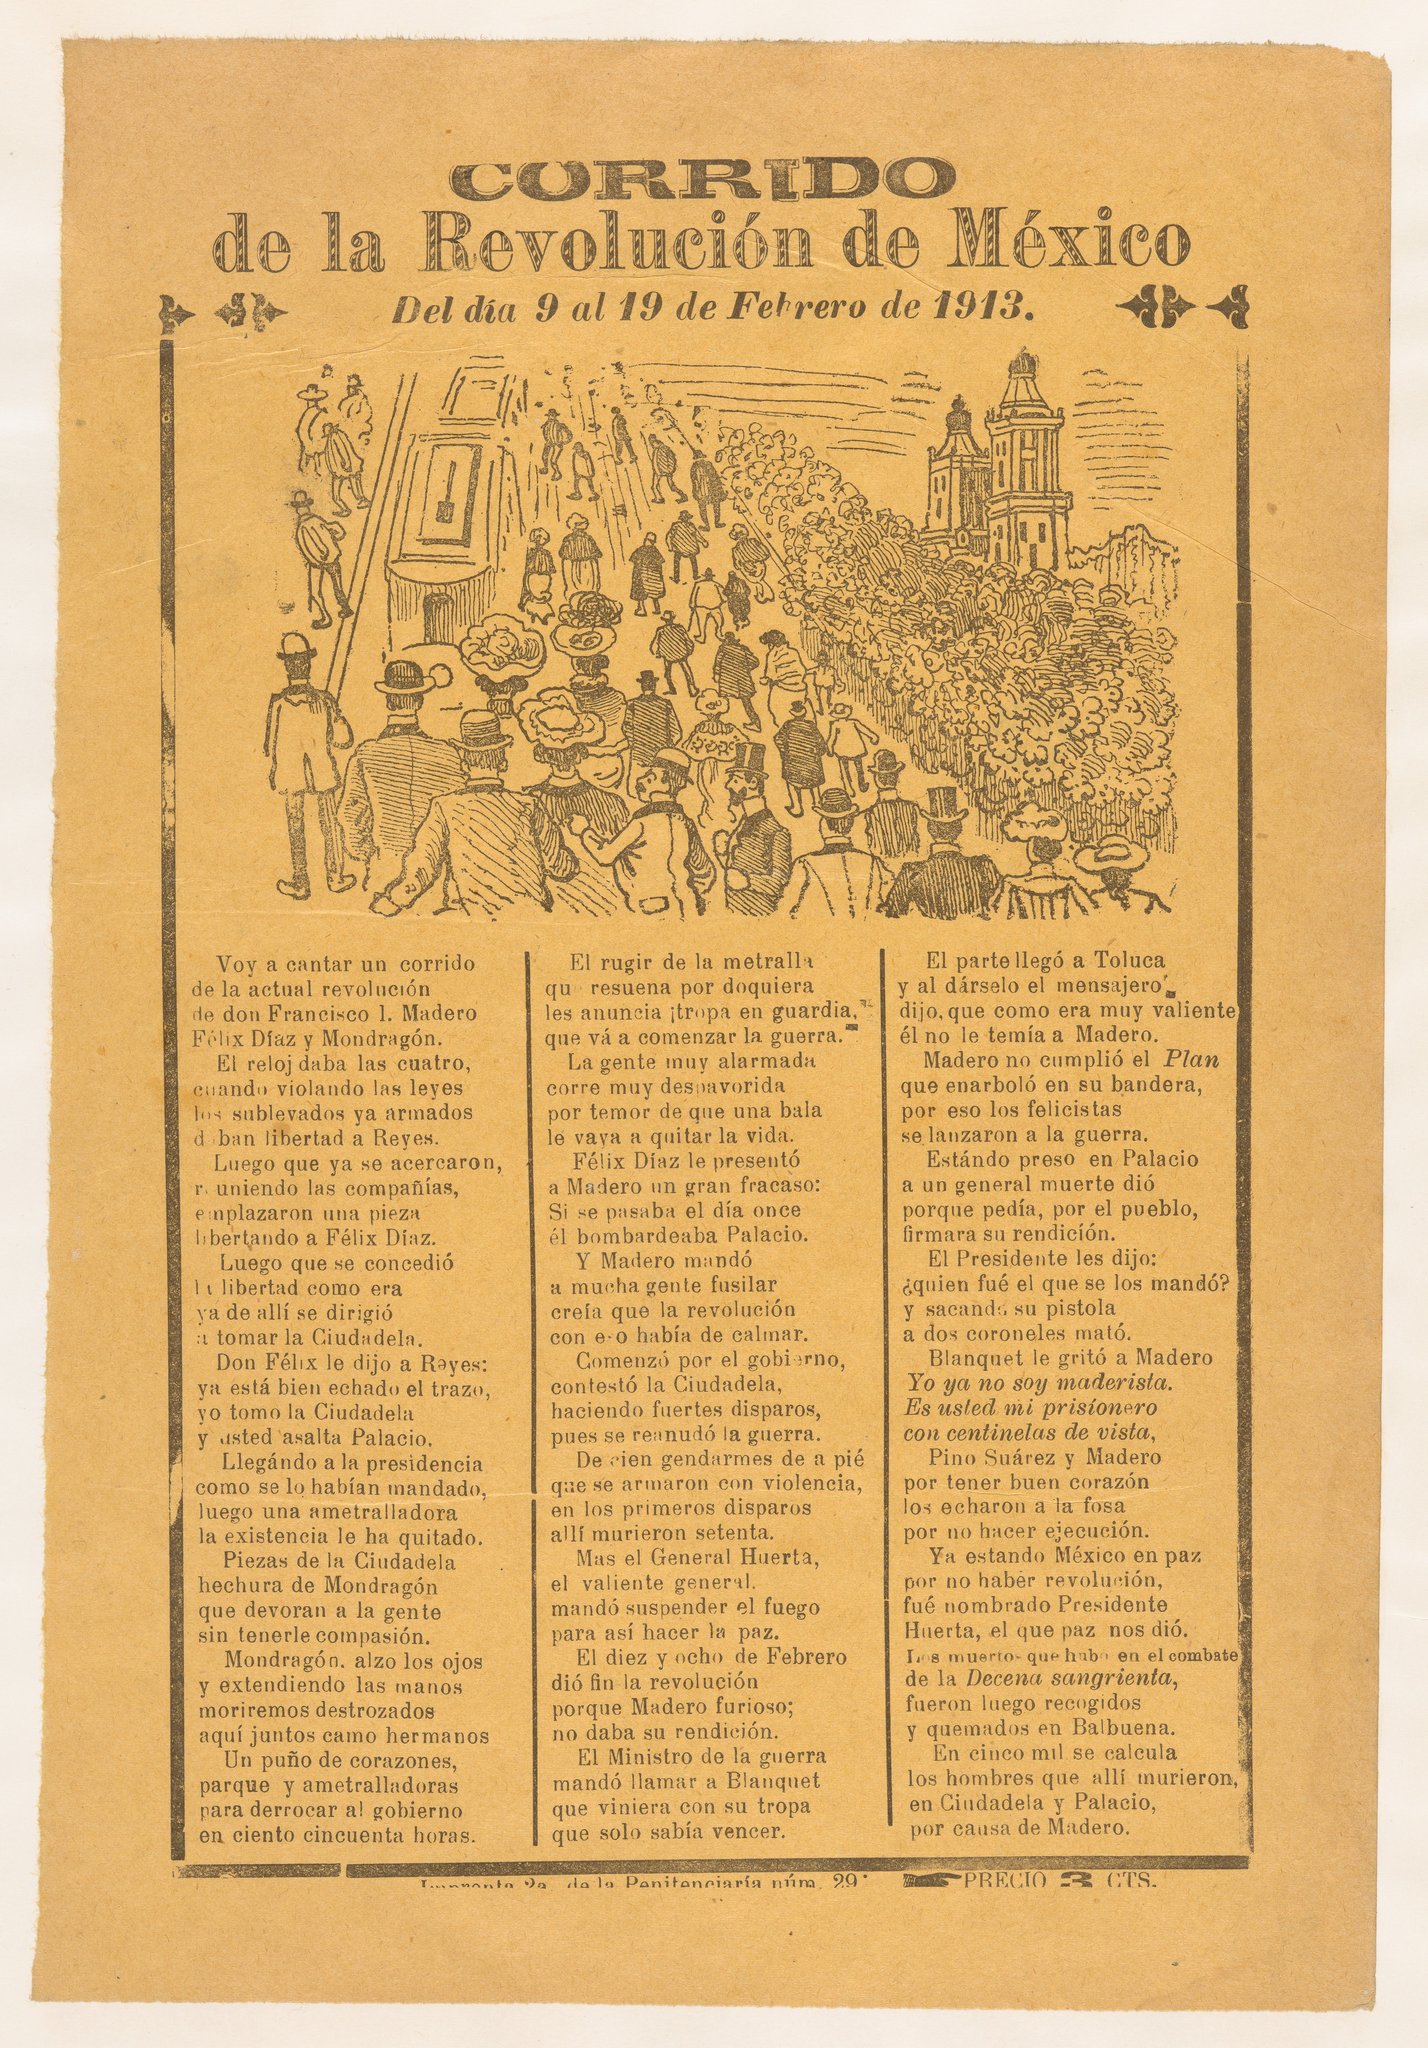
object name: print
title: A ballad of the Mexican Revolution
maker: josé guadalupe posada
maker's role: artist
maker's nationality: mexican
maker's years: 1852-1913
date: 1913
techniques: letterpress, lithography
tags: men,crowd